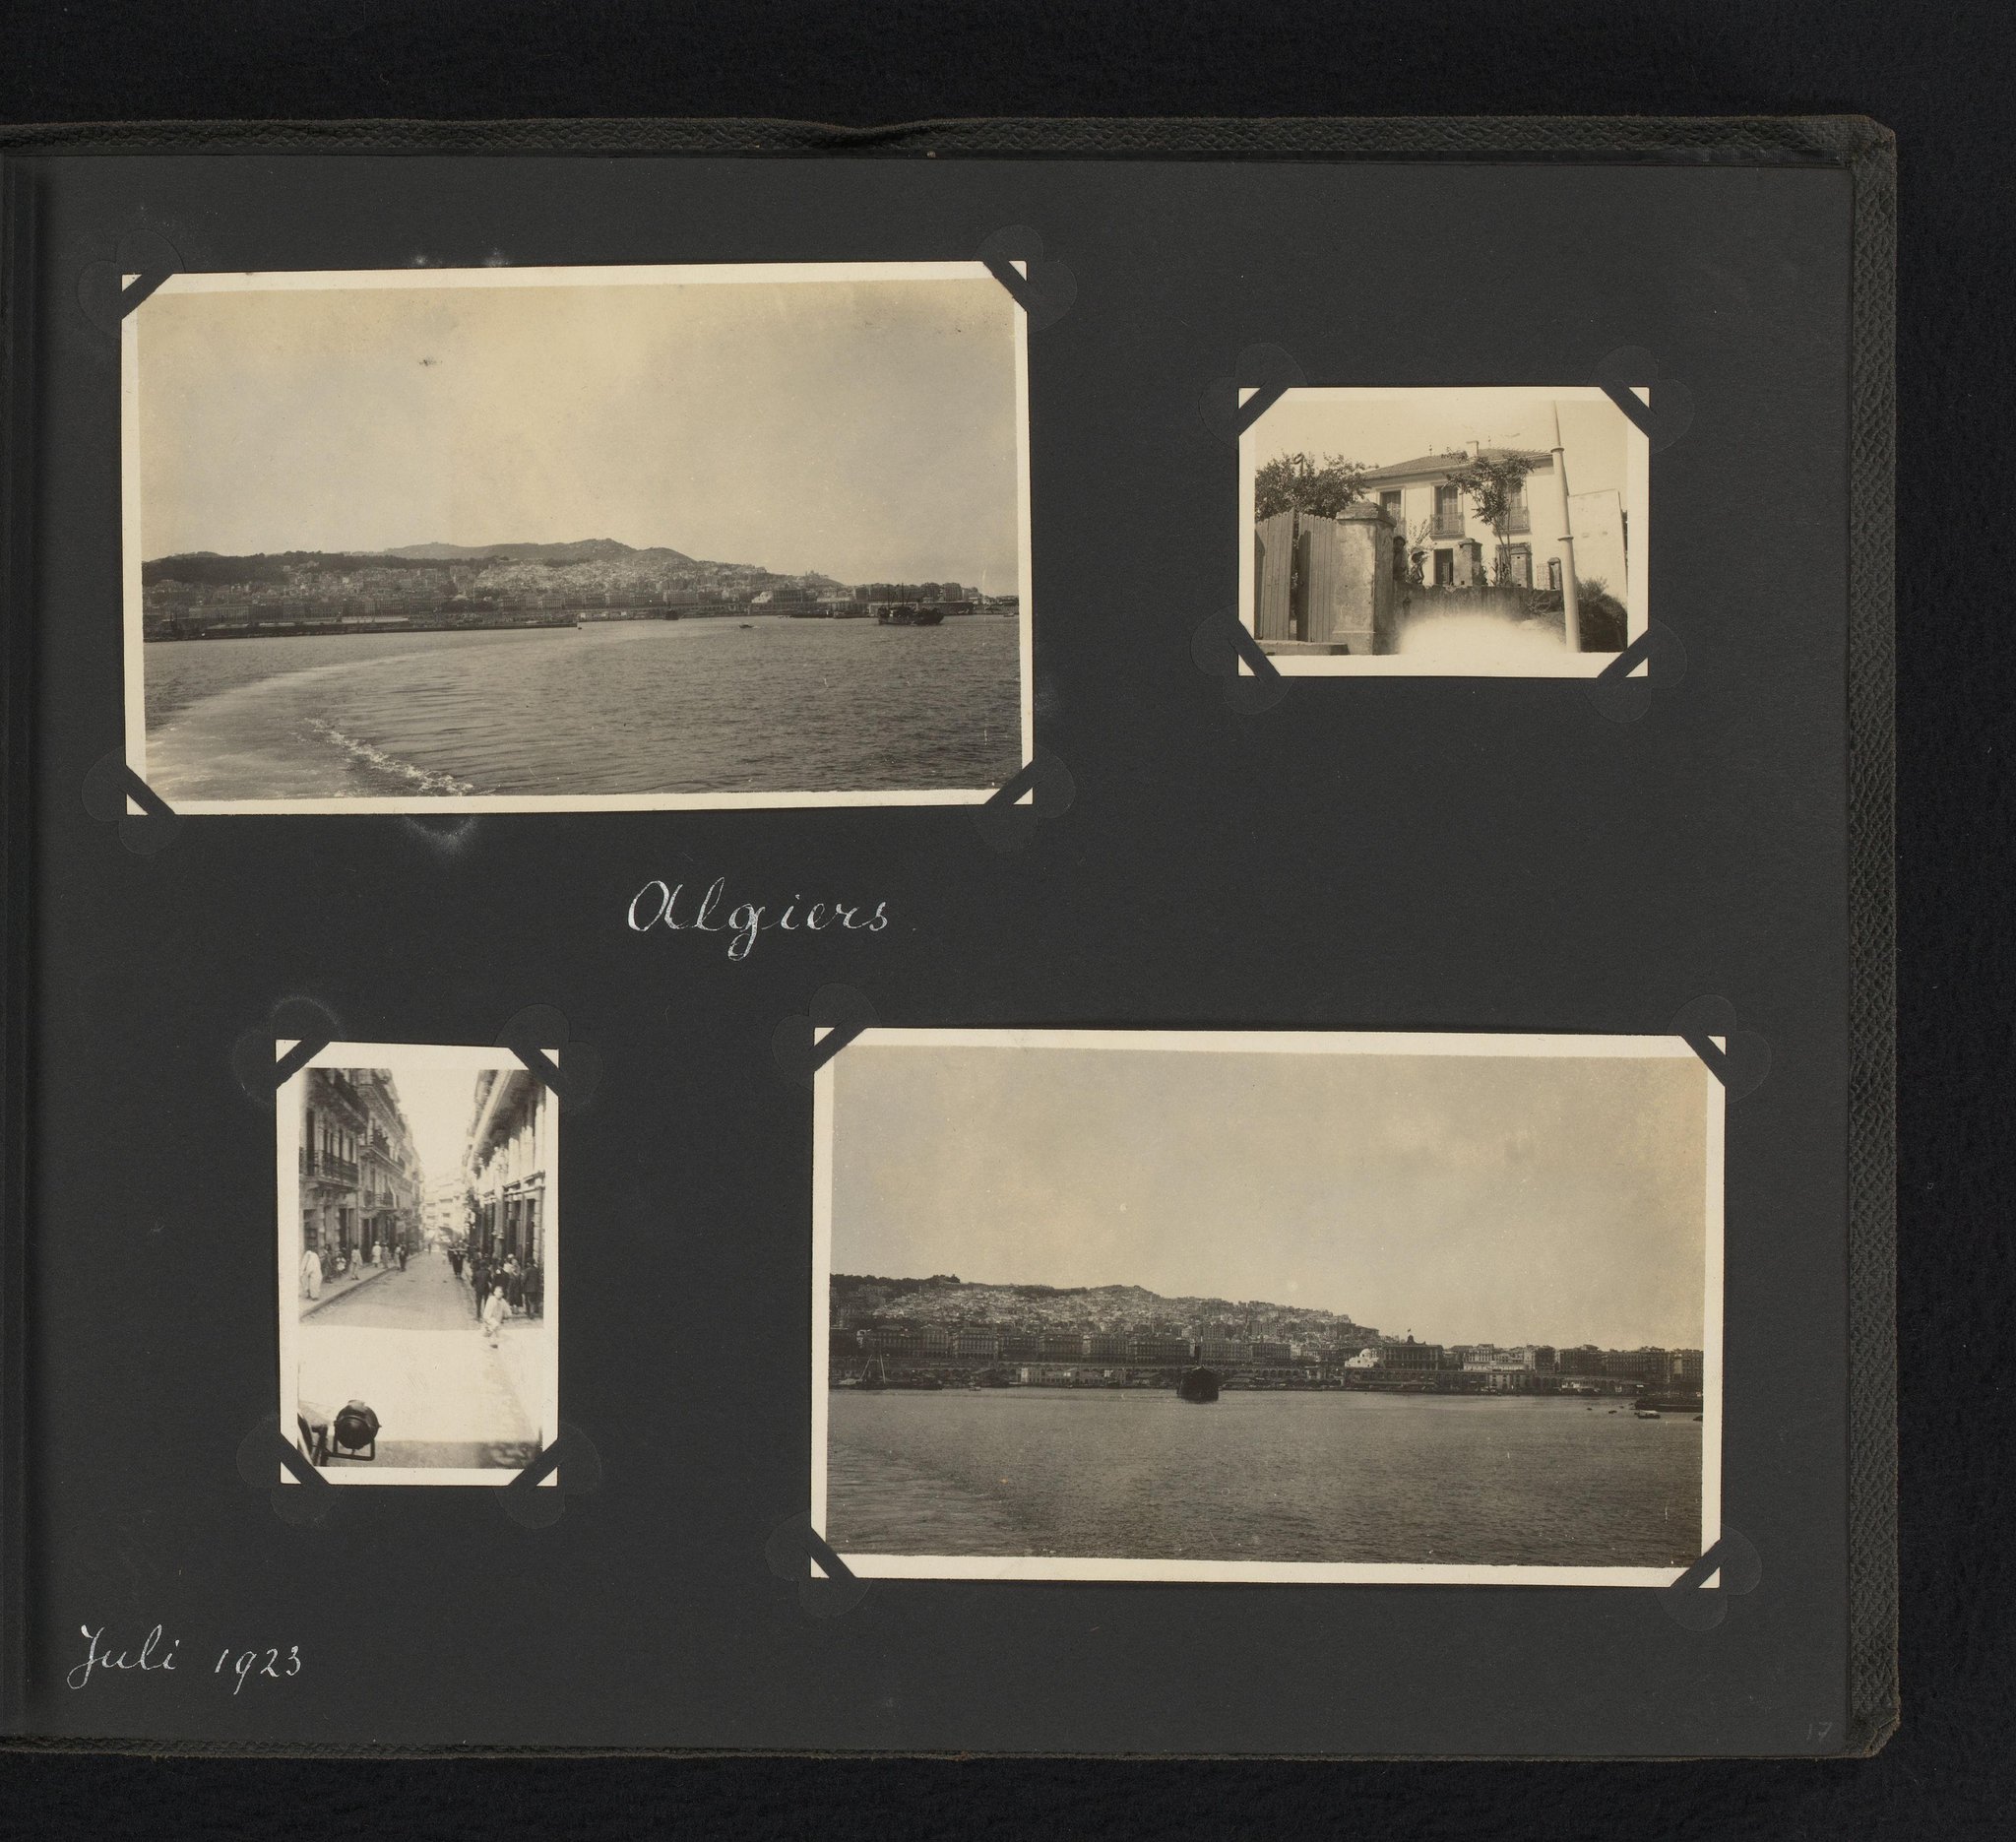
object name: album leaf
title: Vier foto's van straten in Algiers en gezichten op de stad vanaf zee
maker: hendrik herman van den berg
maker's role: amateurfotograaf, jurist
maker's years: 1875-1944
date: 1907-1923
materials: paper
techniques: gelatin silver print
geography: algiers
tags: city-view in general; 'veduta', street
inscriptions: inscription: ‘Algiers’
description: Deze foto's maken deel uit van een album.